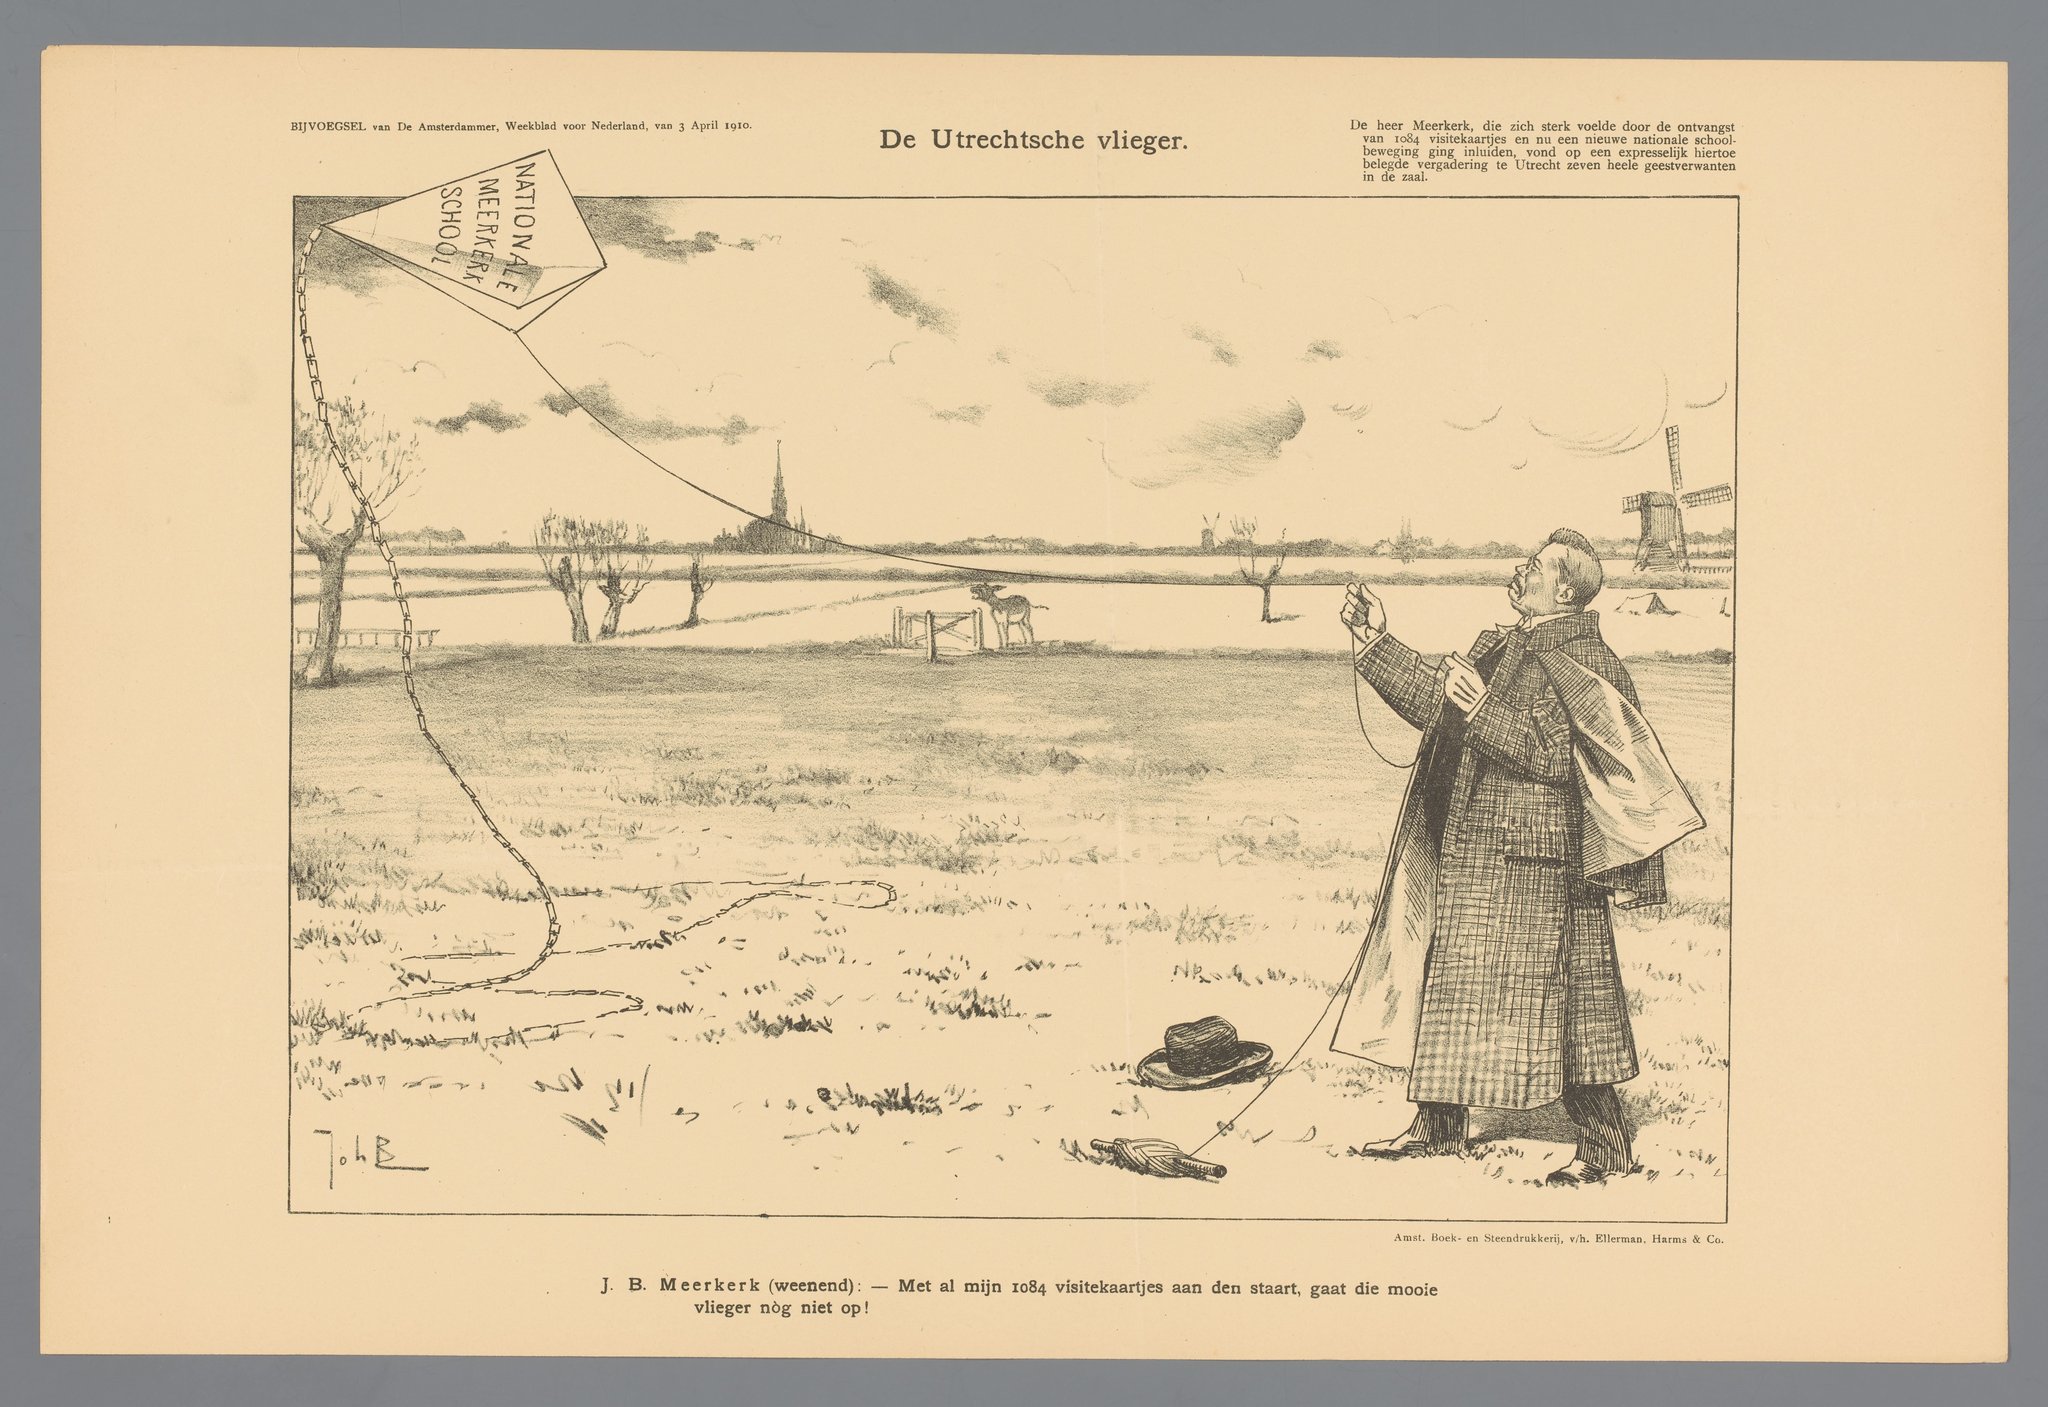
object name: cartoon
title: De Utrechtsche vlieger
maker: johan braakensiek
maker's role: draughtsman, print maker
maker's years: 1858-1940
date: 1910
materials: paper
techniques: lithograph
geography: amsterdam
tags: (flying a) kite, political caricatures and satires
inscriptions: date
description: Prent uit het bijvoegsel van: De Amsterdammer. Weekblad voor Nederland, 3 april 1910.